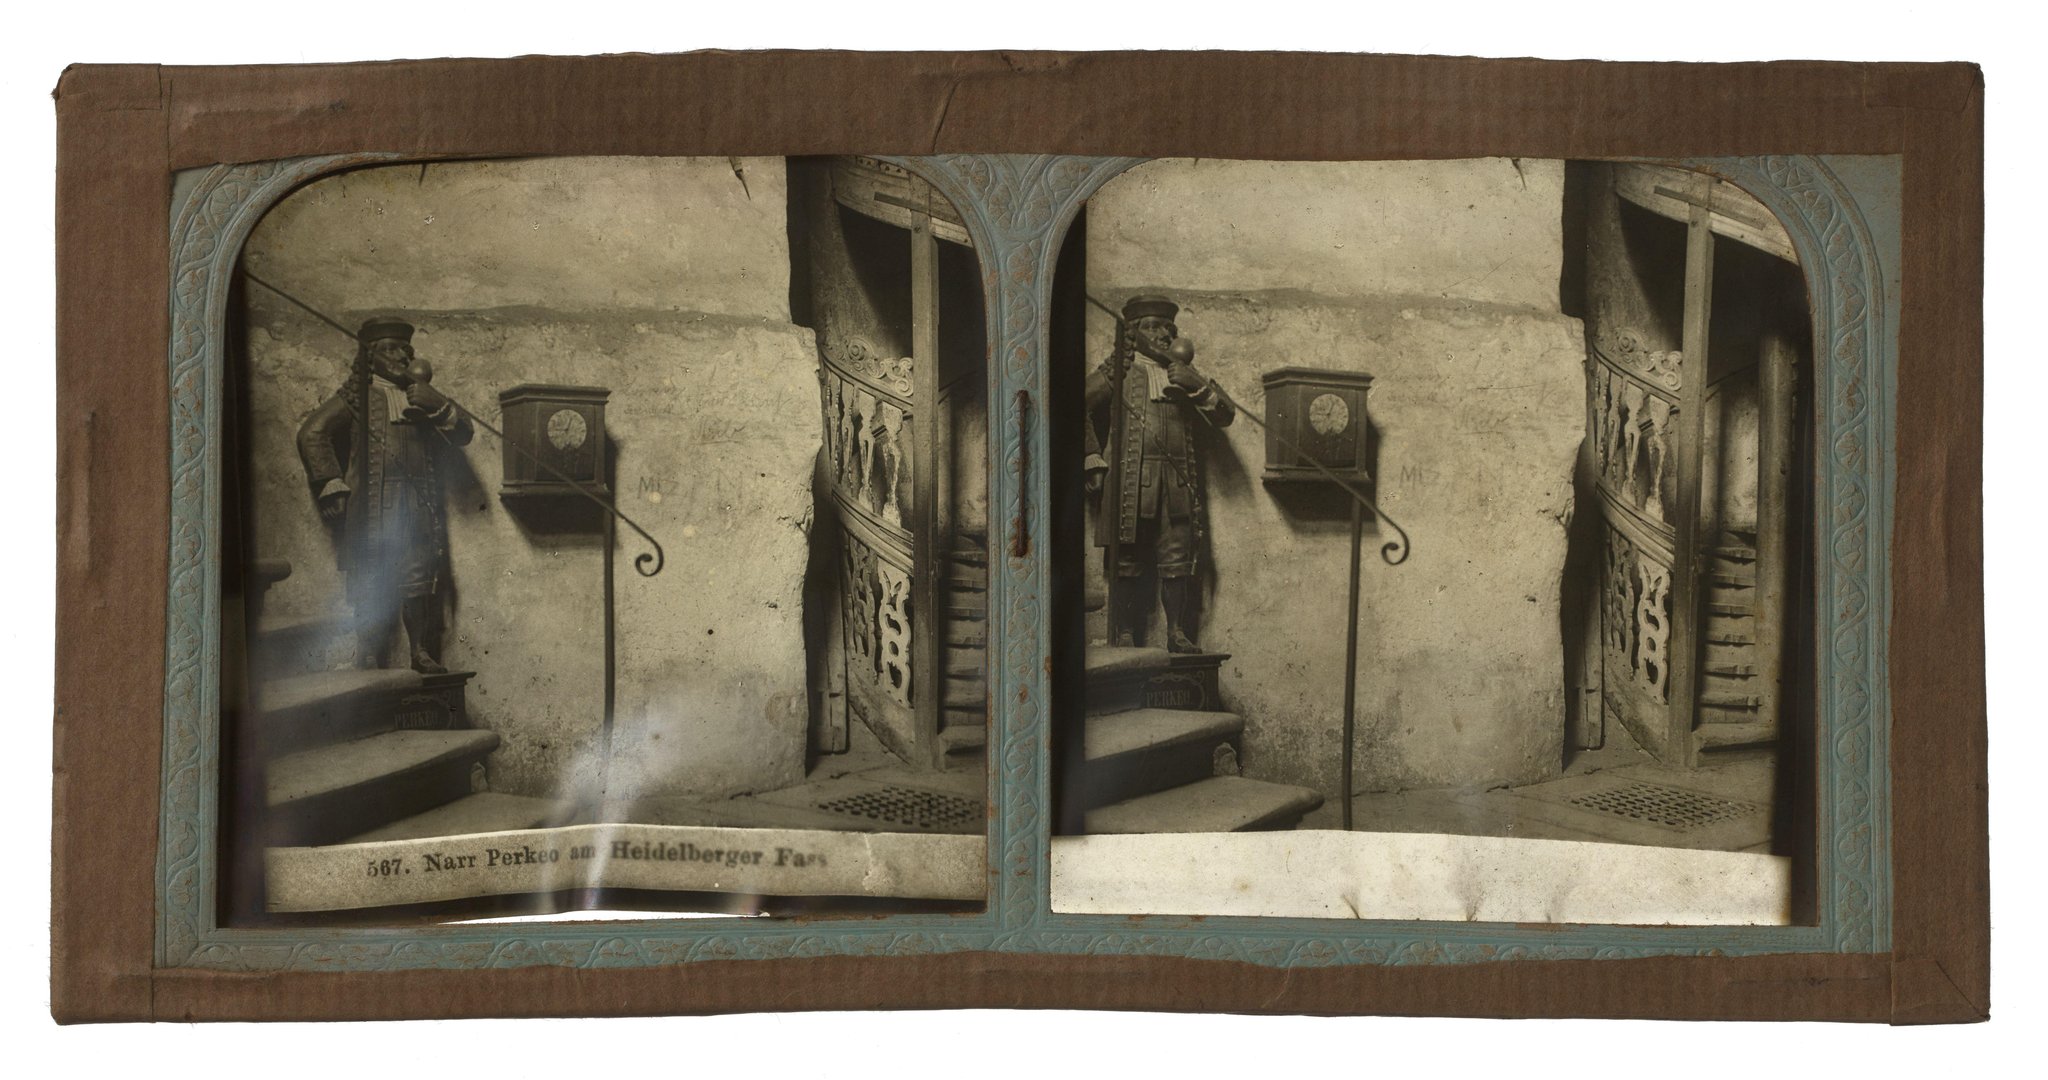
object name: stereograph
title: Standbeeld van de dwaas Perkeo in het Heidelberger Vat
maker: Anonymous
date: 1900-1940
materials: cardboard, film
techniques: gelatin silver print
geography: heidelberg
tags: wine-cellar, piece of sculpture, reproduction of a piece of sculpture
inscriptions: number: ‘567.’